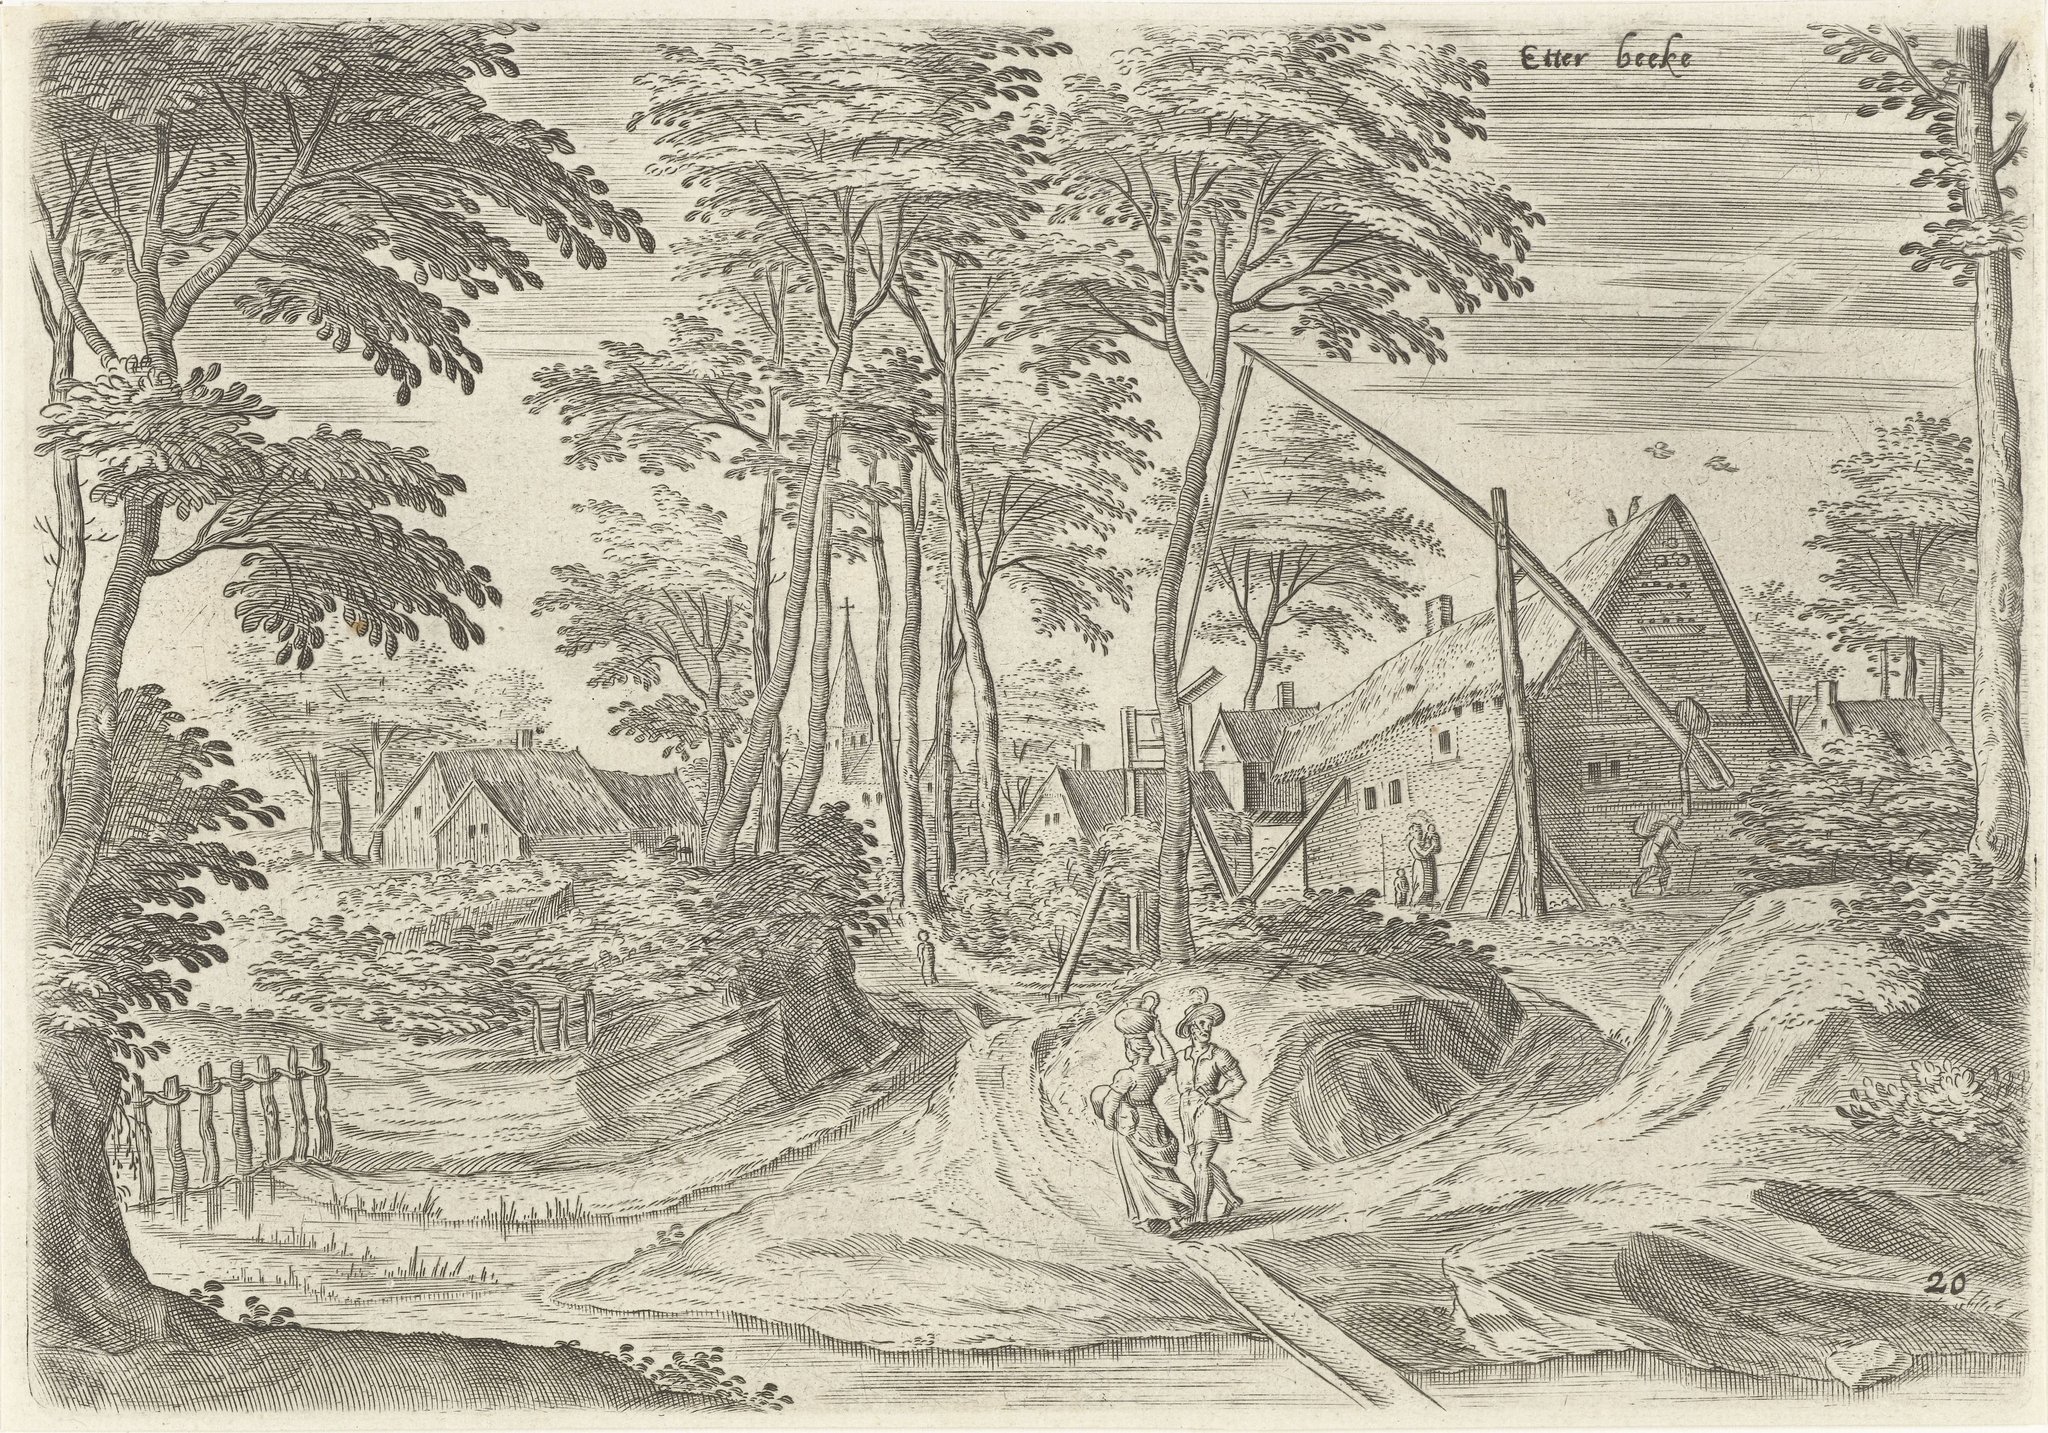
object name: print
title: Gezichten uit de omgeving van Brussel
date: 1530-1580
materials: paper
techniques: engraving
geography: antwerp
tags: village (+ city(-scape) with figures, staffage)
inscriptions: collector's mark: Lugt 2228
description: Gezicht op het gehucht Etterbeek, vlakbij Brussel. De prent is deel van een serie met gezichten uit de omgeving van Brussel.